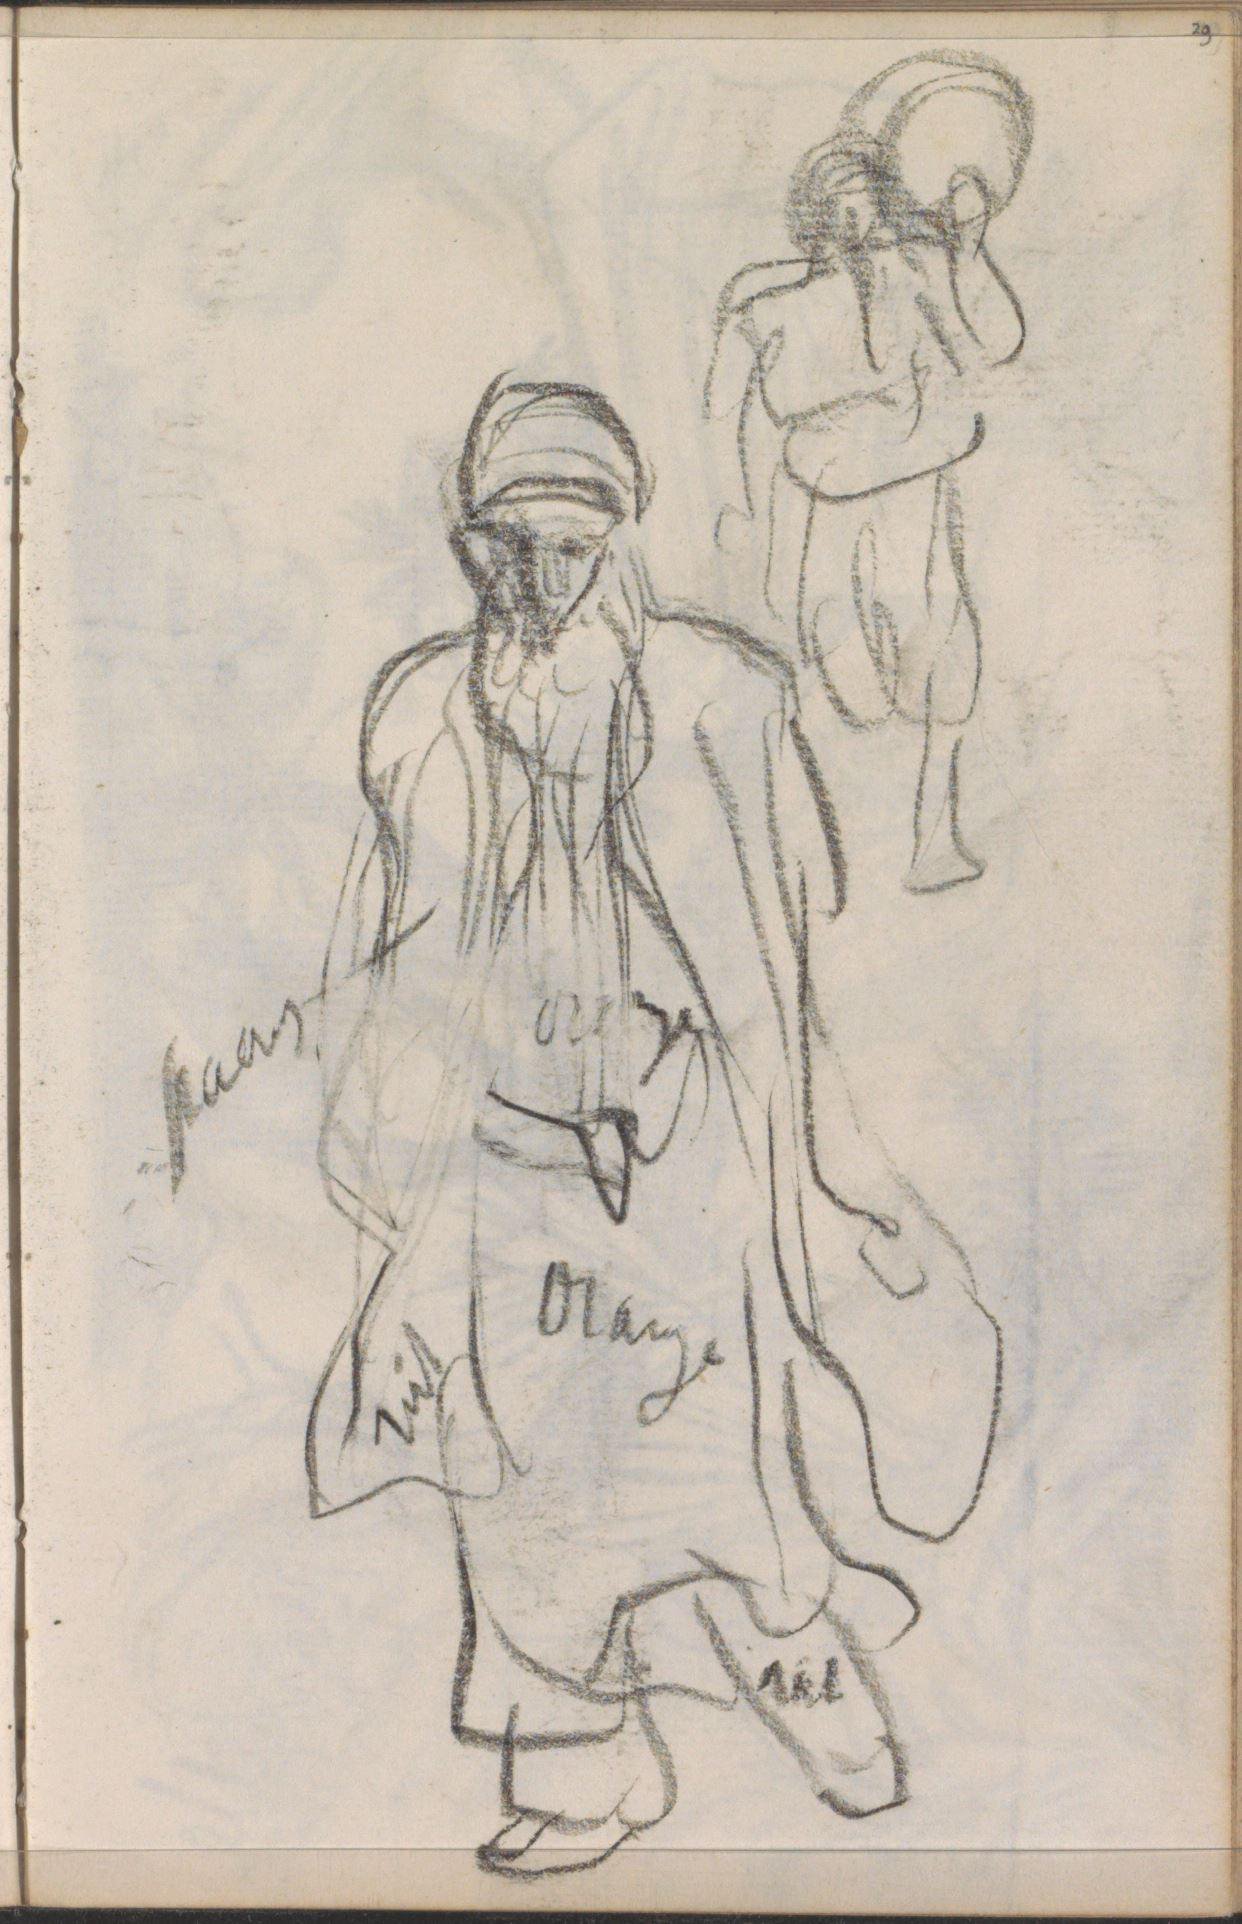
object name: sketchbook leaf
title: Twee mannen in oosterse kleding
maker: marius bauer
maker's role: draughtsman, print maker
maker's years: 1867-1932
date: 1899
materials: chalk, paper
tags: asiatic races and peoples, adult man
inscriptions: kleurnotitie, handgeschreven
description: Pagina 29 uit een schetsboek met 42 bladen.